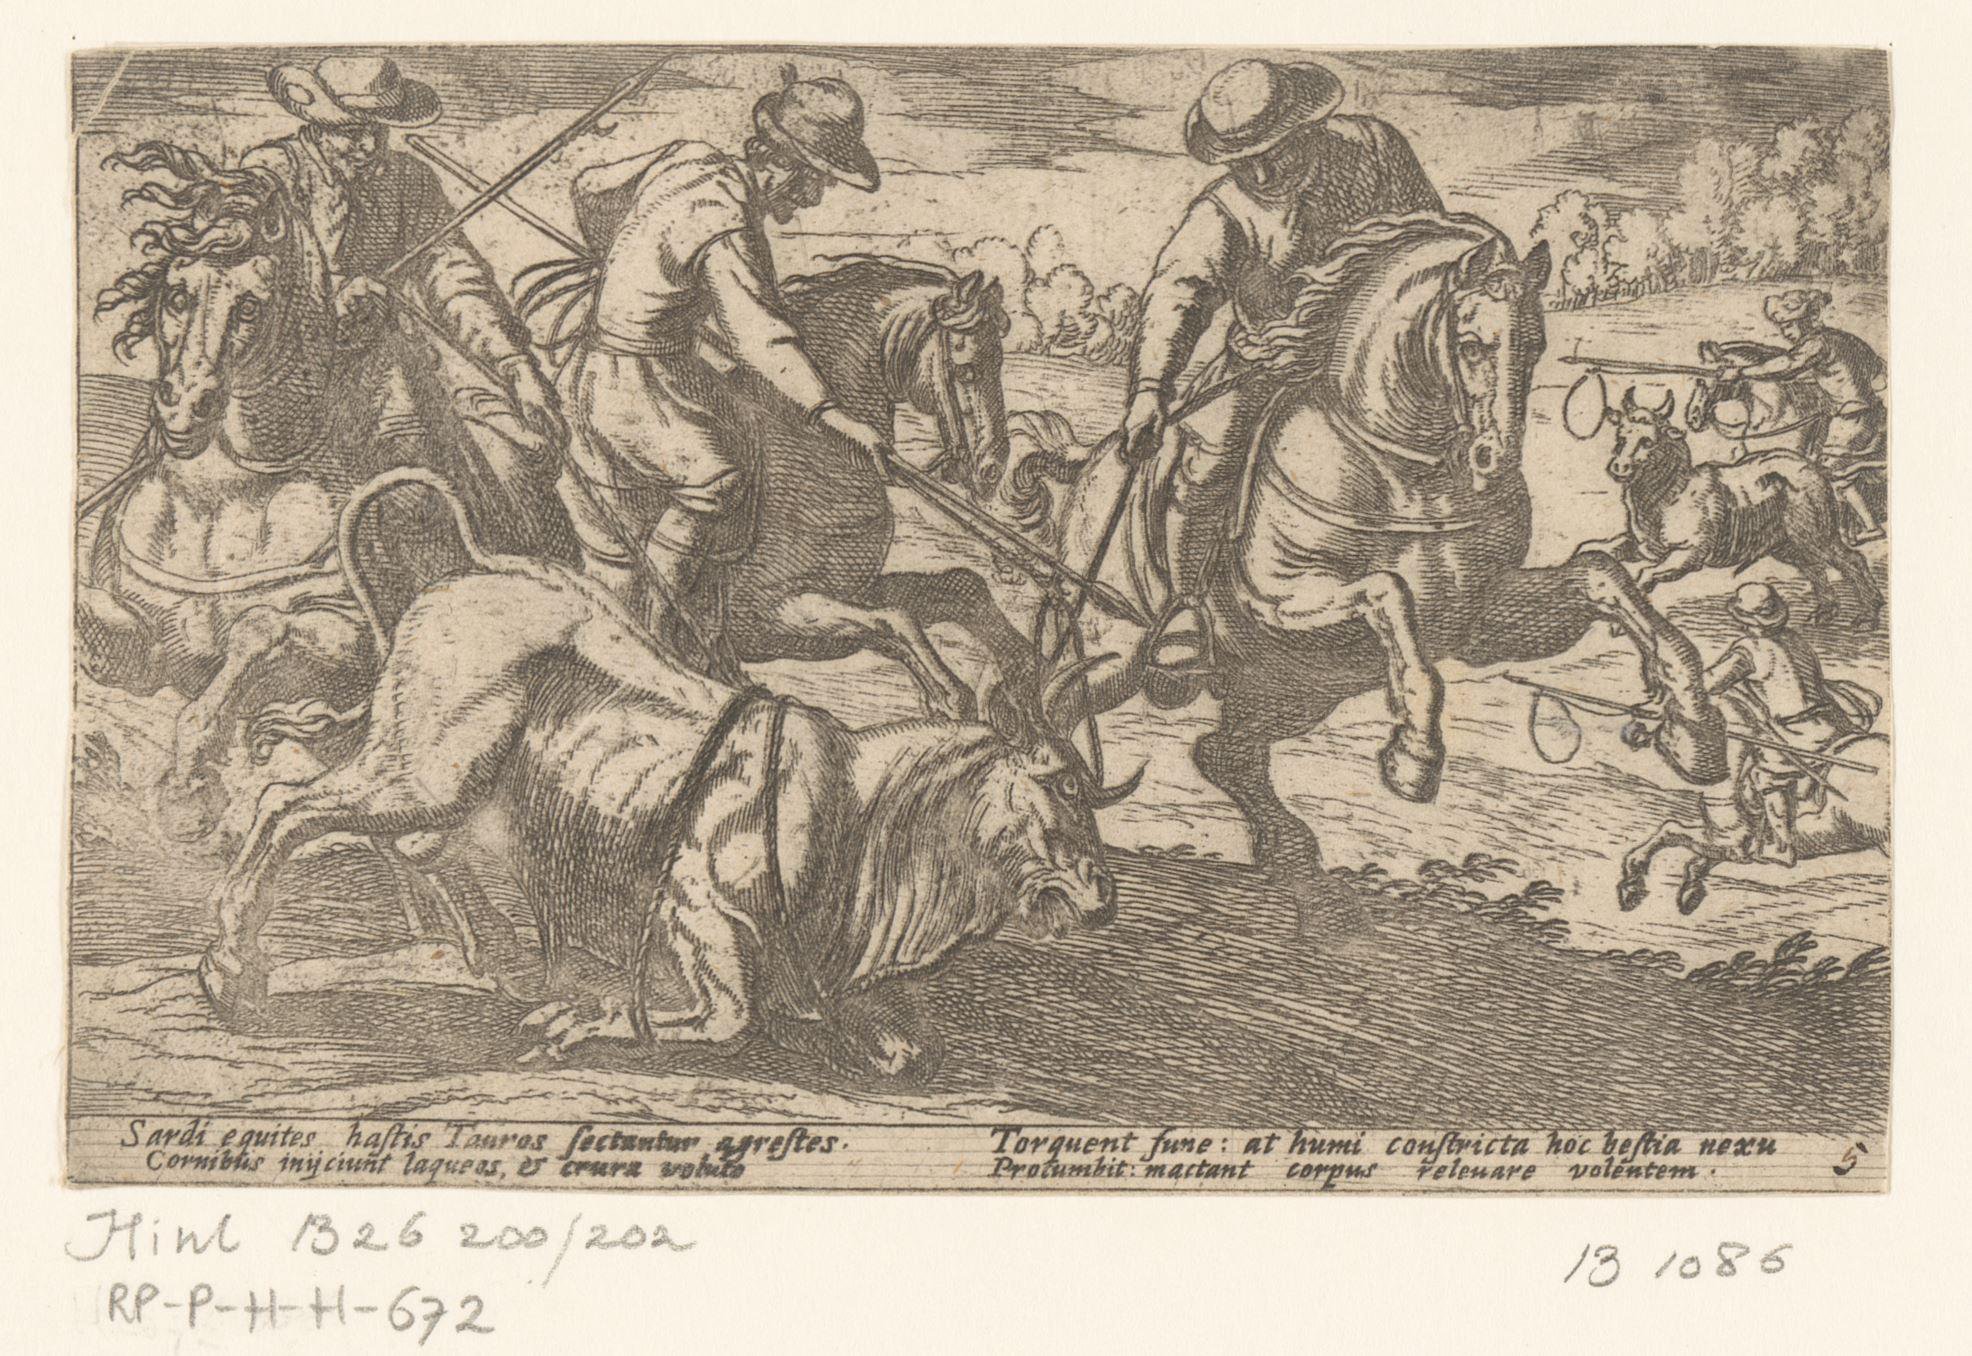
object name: print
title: Diverse jacht- en strijdscènes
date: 1605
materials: paper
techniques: etching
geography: italy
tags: hunter, hunters hunting (n.b.: in 1988-1990 this notation denoted the concept of 43c11421 'hunters resting during the hunt'), ox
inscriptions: number: ‘5’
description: Landschap met jagers te paard die wilde ossen vangen met behulp van speren en touwen. Tekst in het Latijn in ondermarge.